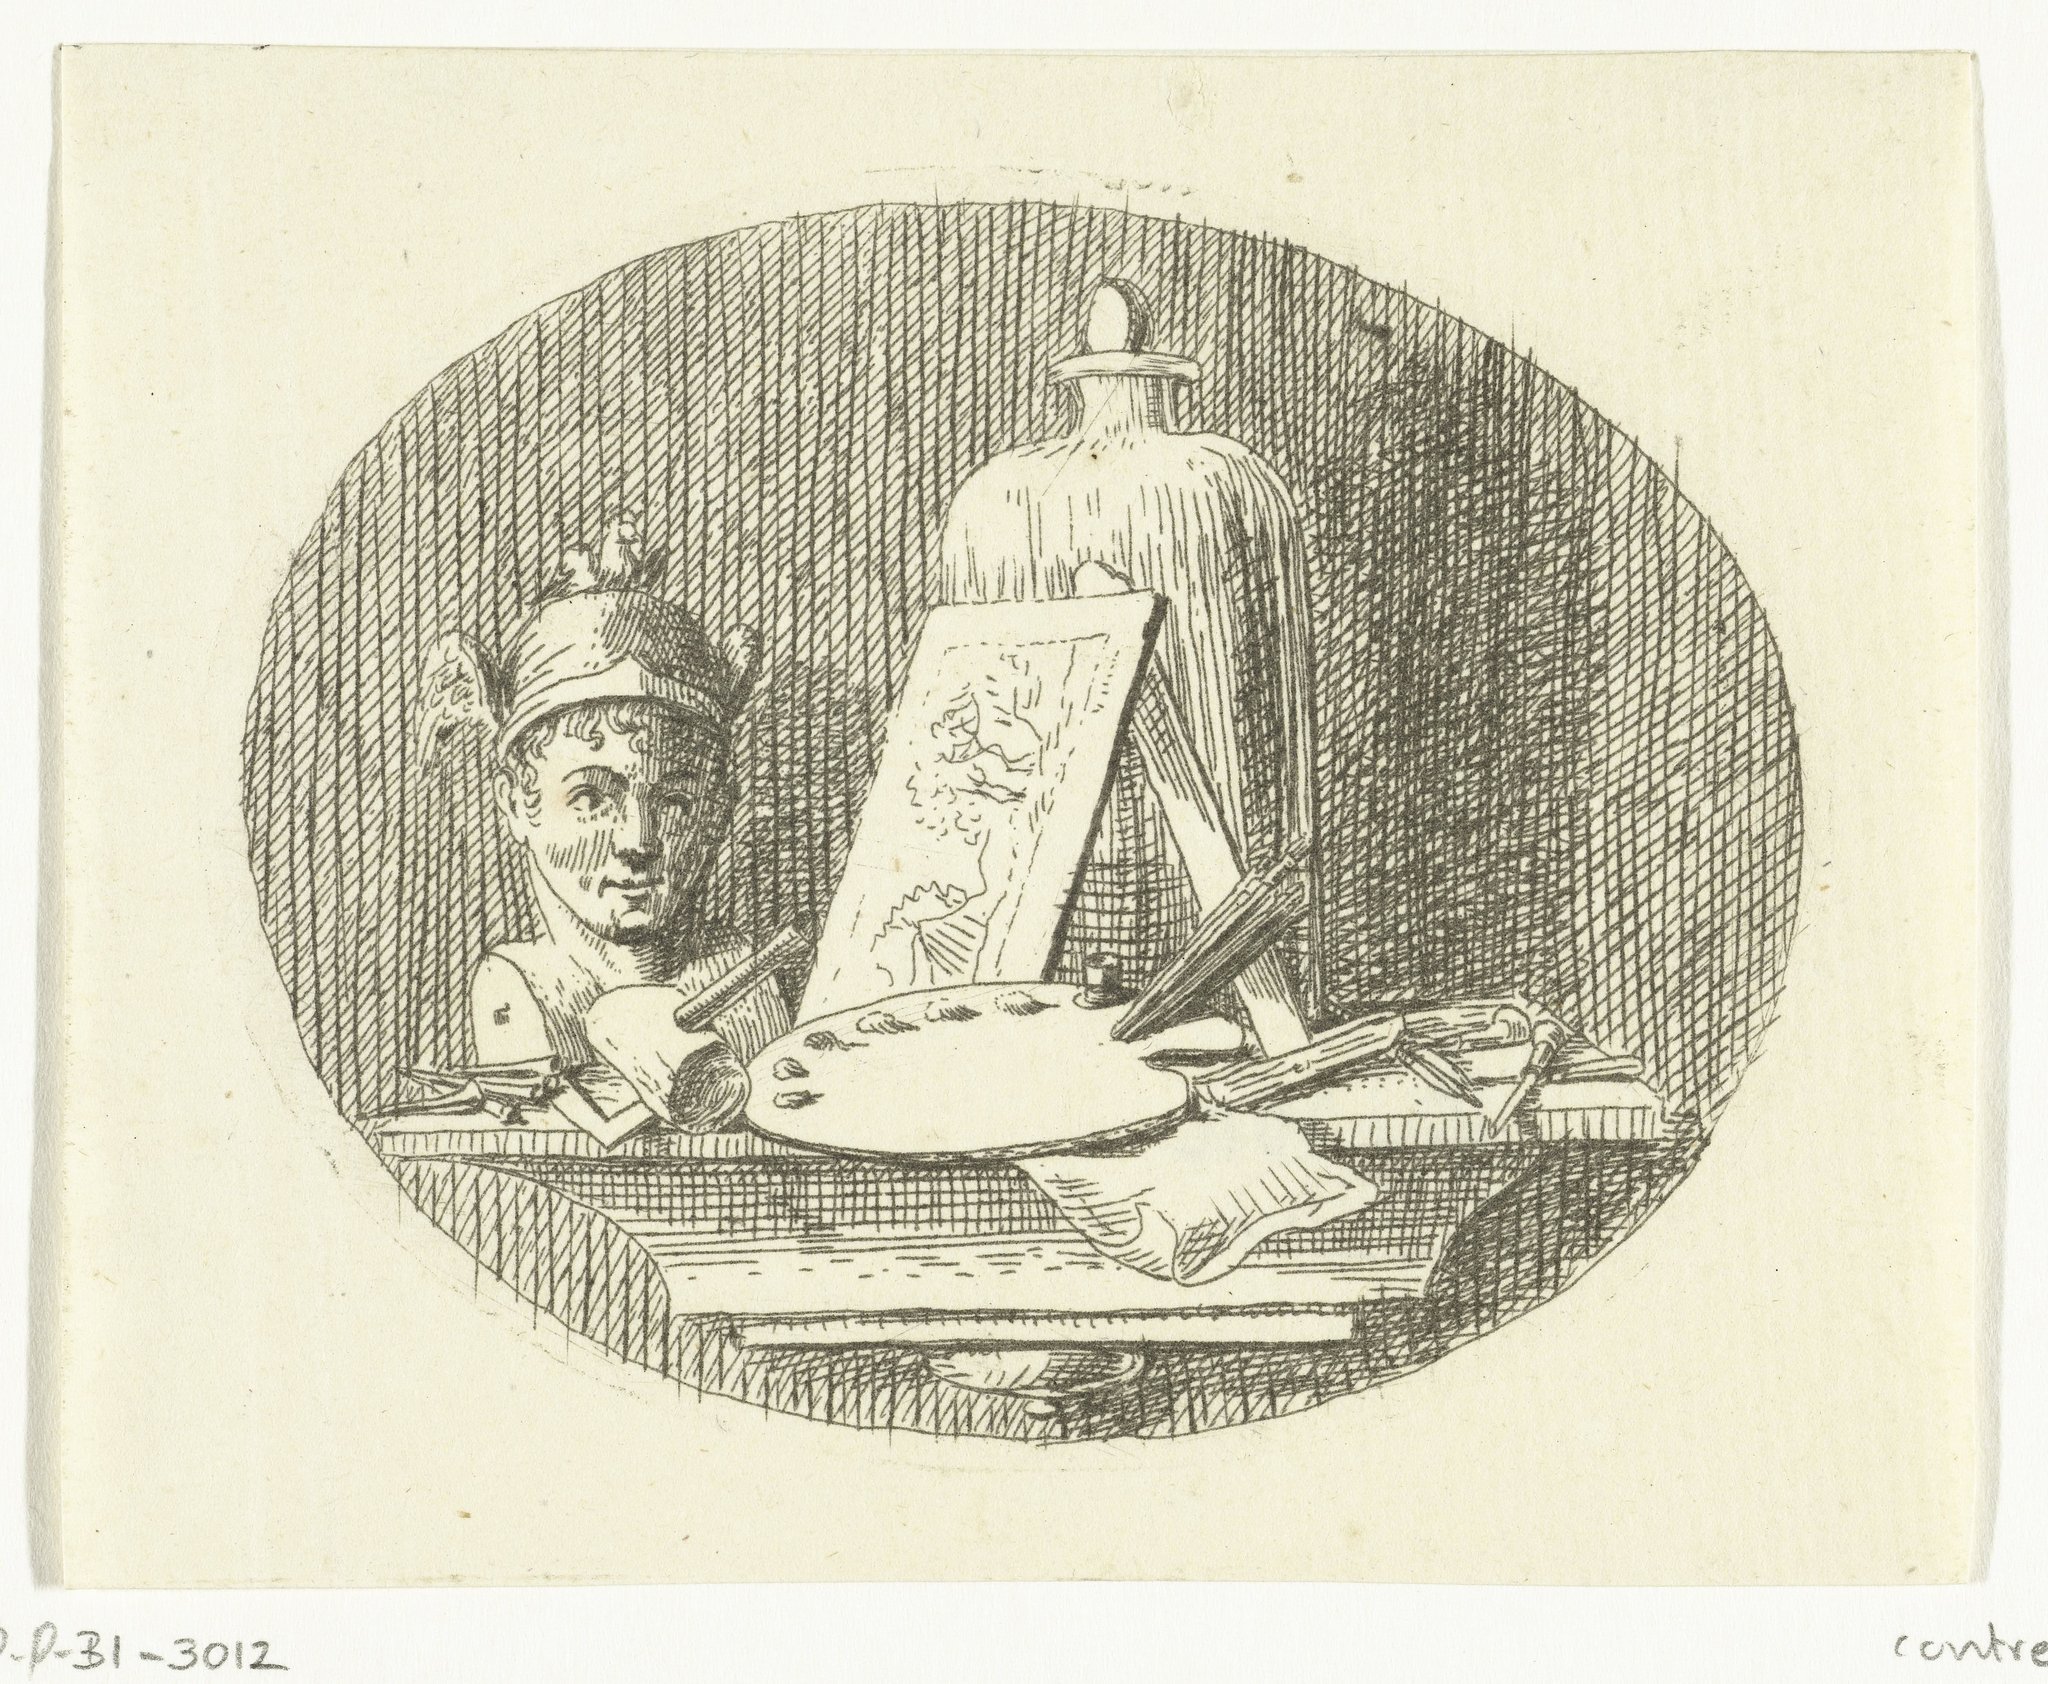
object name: print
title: Stilleven met palet, schilderij en buste van Mercurius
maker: anthonie van den bos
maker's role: draughtsman, print maker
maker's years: 1763-1838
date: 1778-1838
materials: paper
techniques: printmaking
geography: netherlands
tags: (story of) mercury (hermes), still life of related objects, tools, implements of painter, palette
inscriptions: collector's mark: Lugt 2228